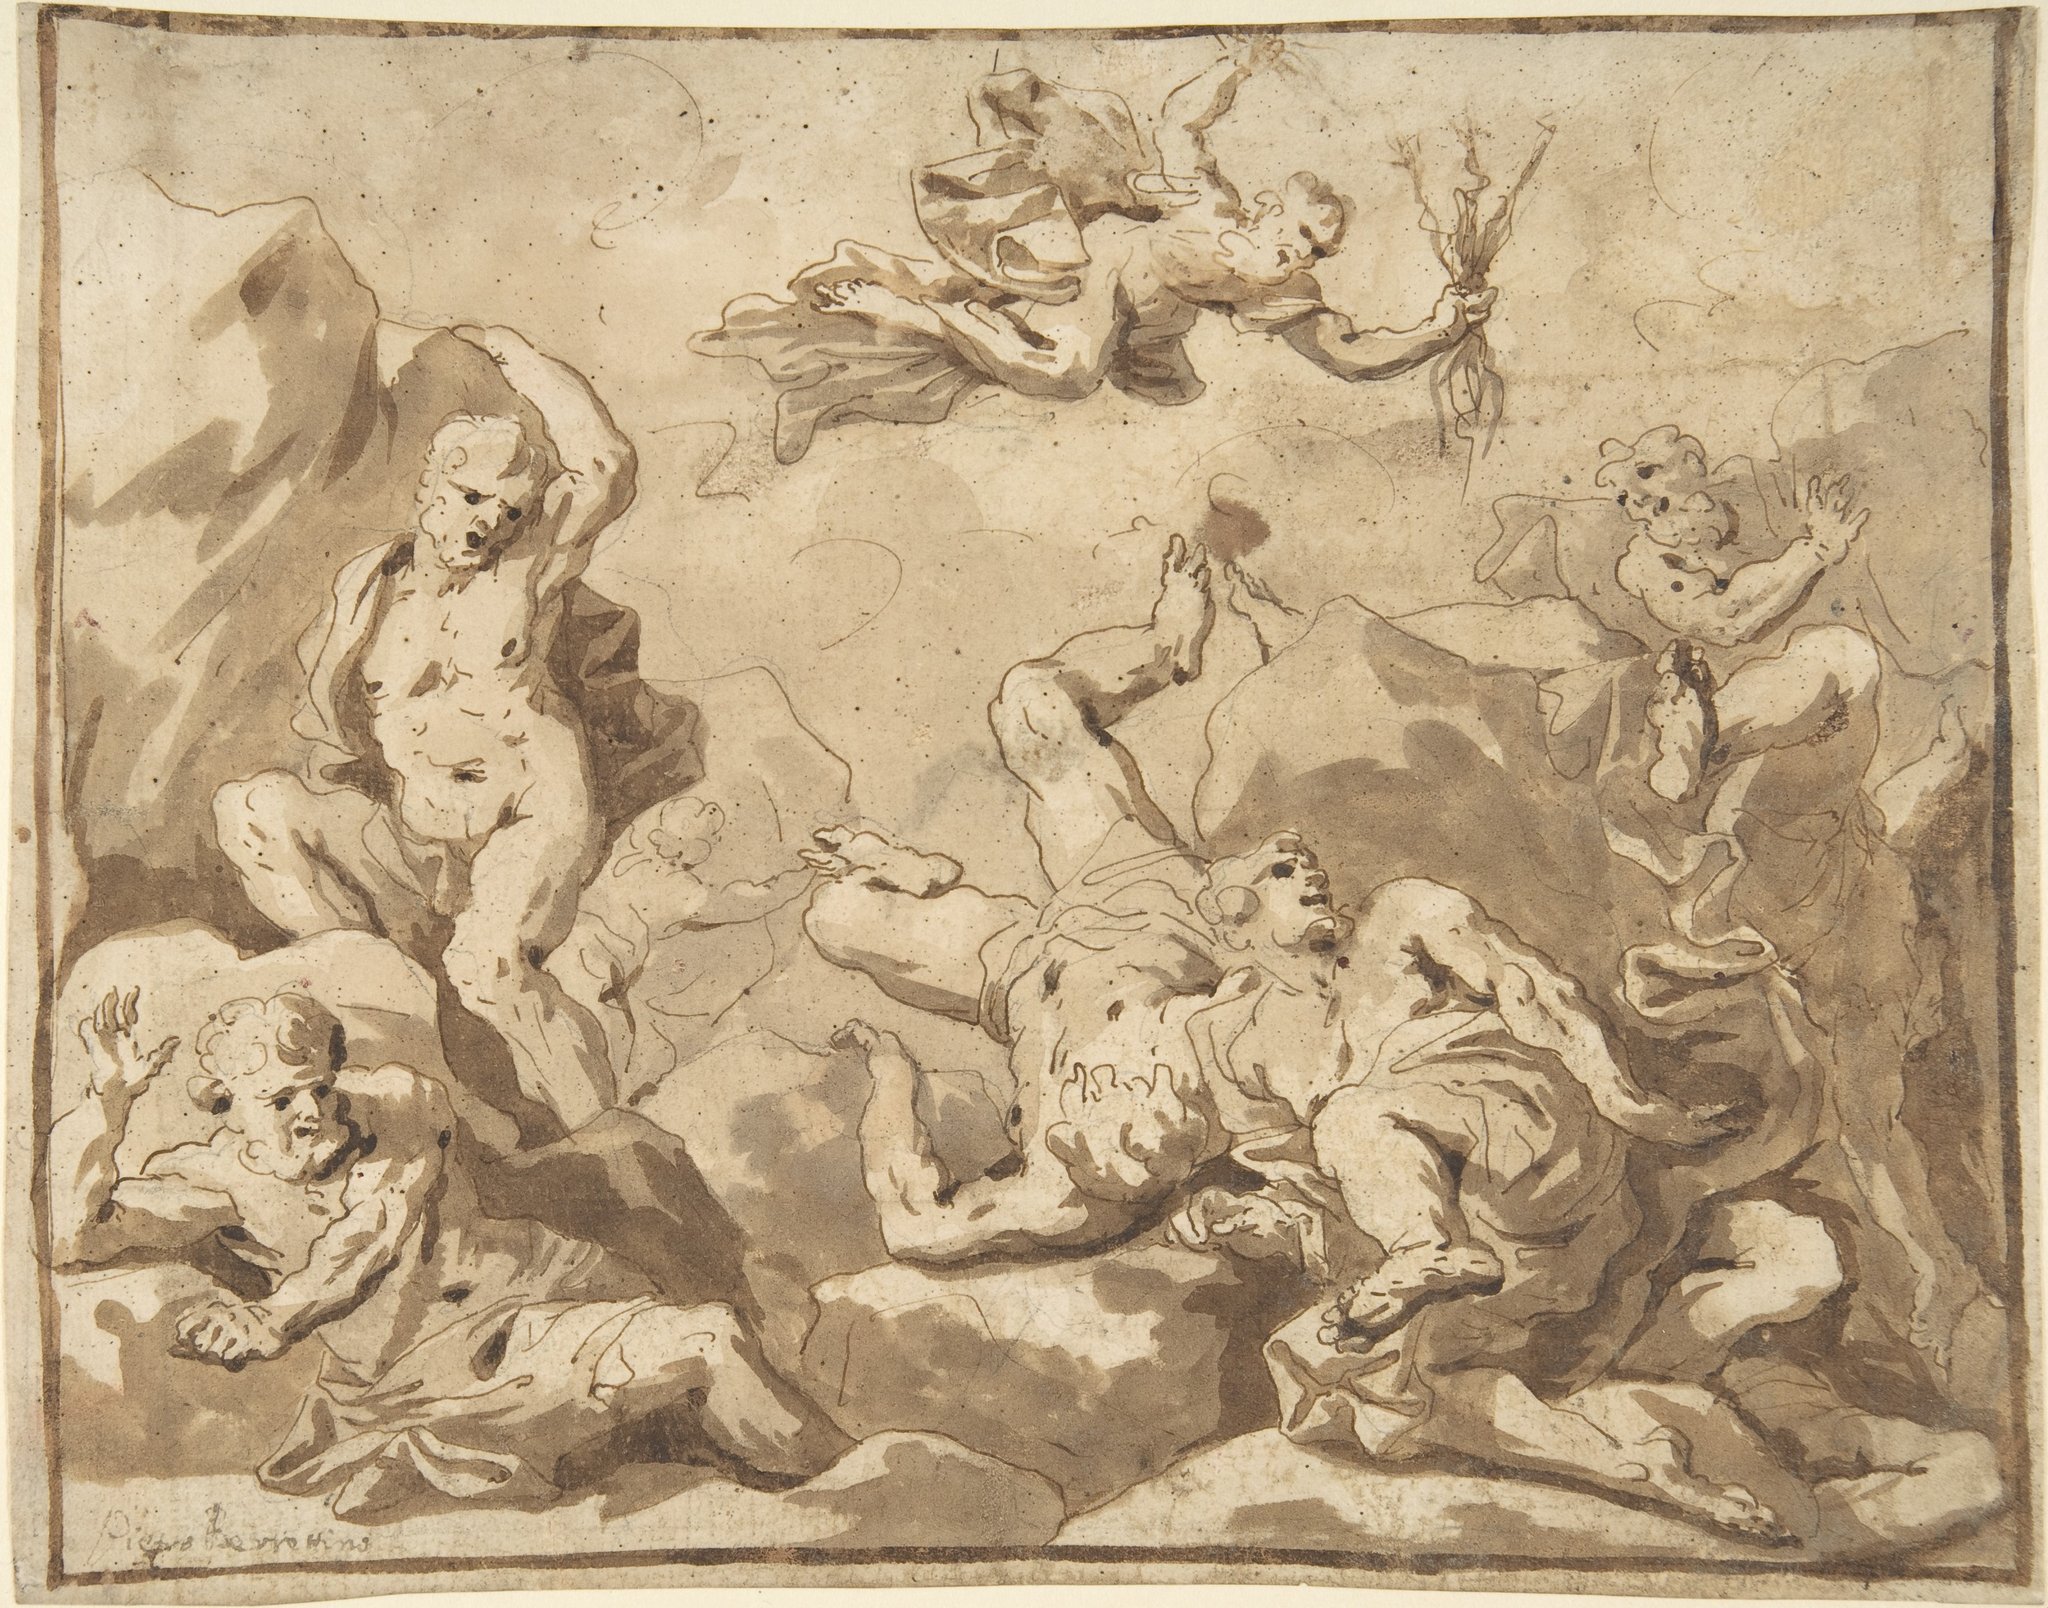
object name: drawing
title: Fall of the Giants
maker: anonymous, italian, roman-bolognese, 17th century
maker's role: artist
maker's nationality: italian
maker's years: 1600-1700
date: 1601-1700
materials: chalk, ink, paper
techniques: brush, pen, wash